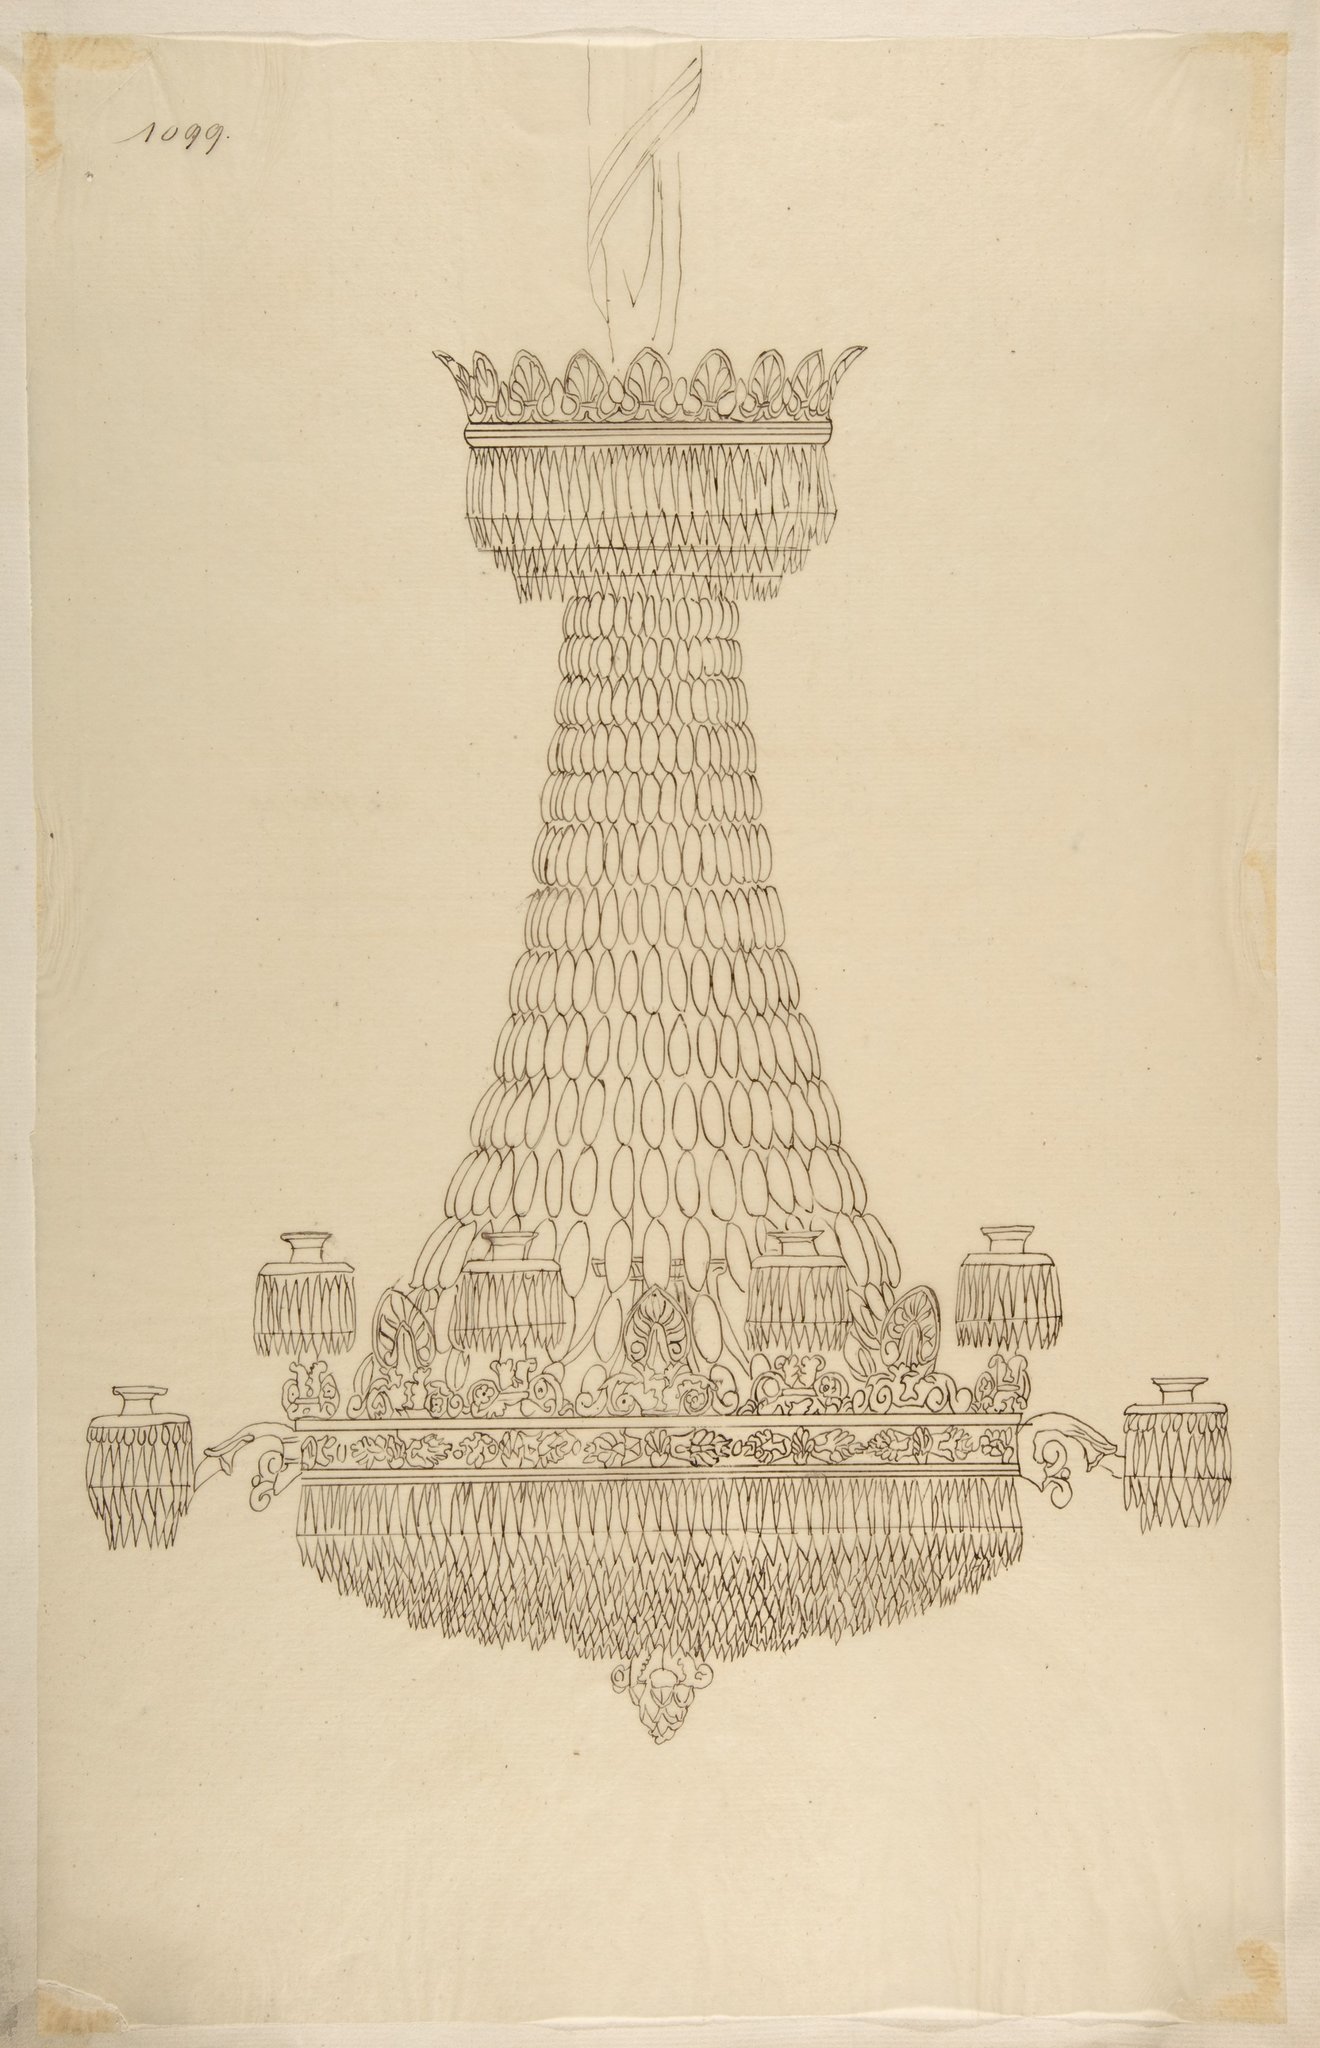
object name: drawing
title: Design for a Chandelier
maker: anonymous, french, 19th century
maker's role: artist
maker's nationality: french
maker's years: 1800-1900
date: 1801-1900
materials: ink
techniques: pen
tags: chandelier